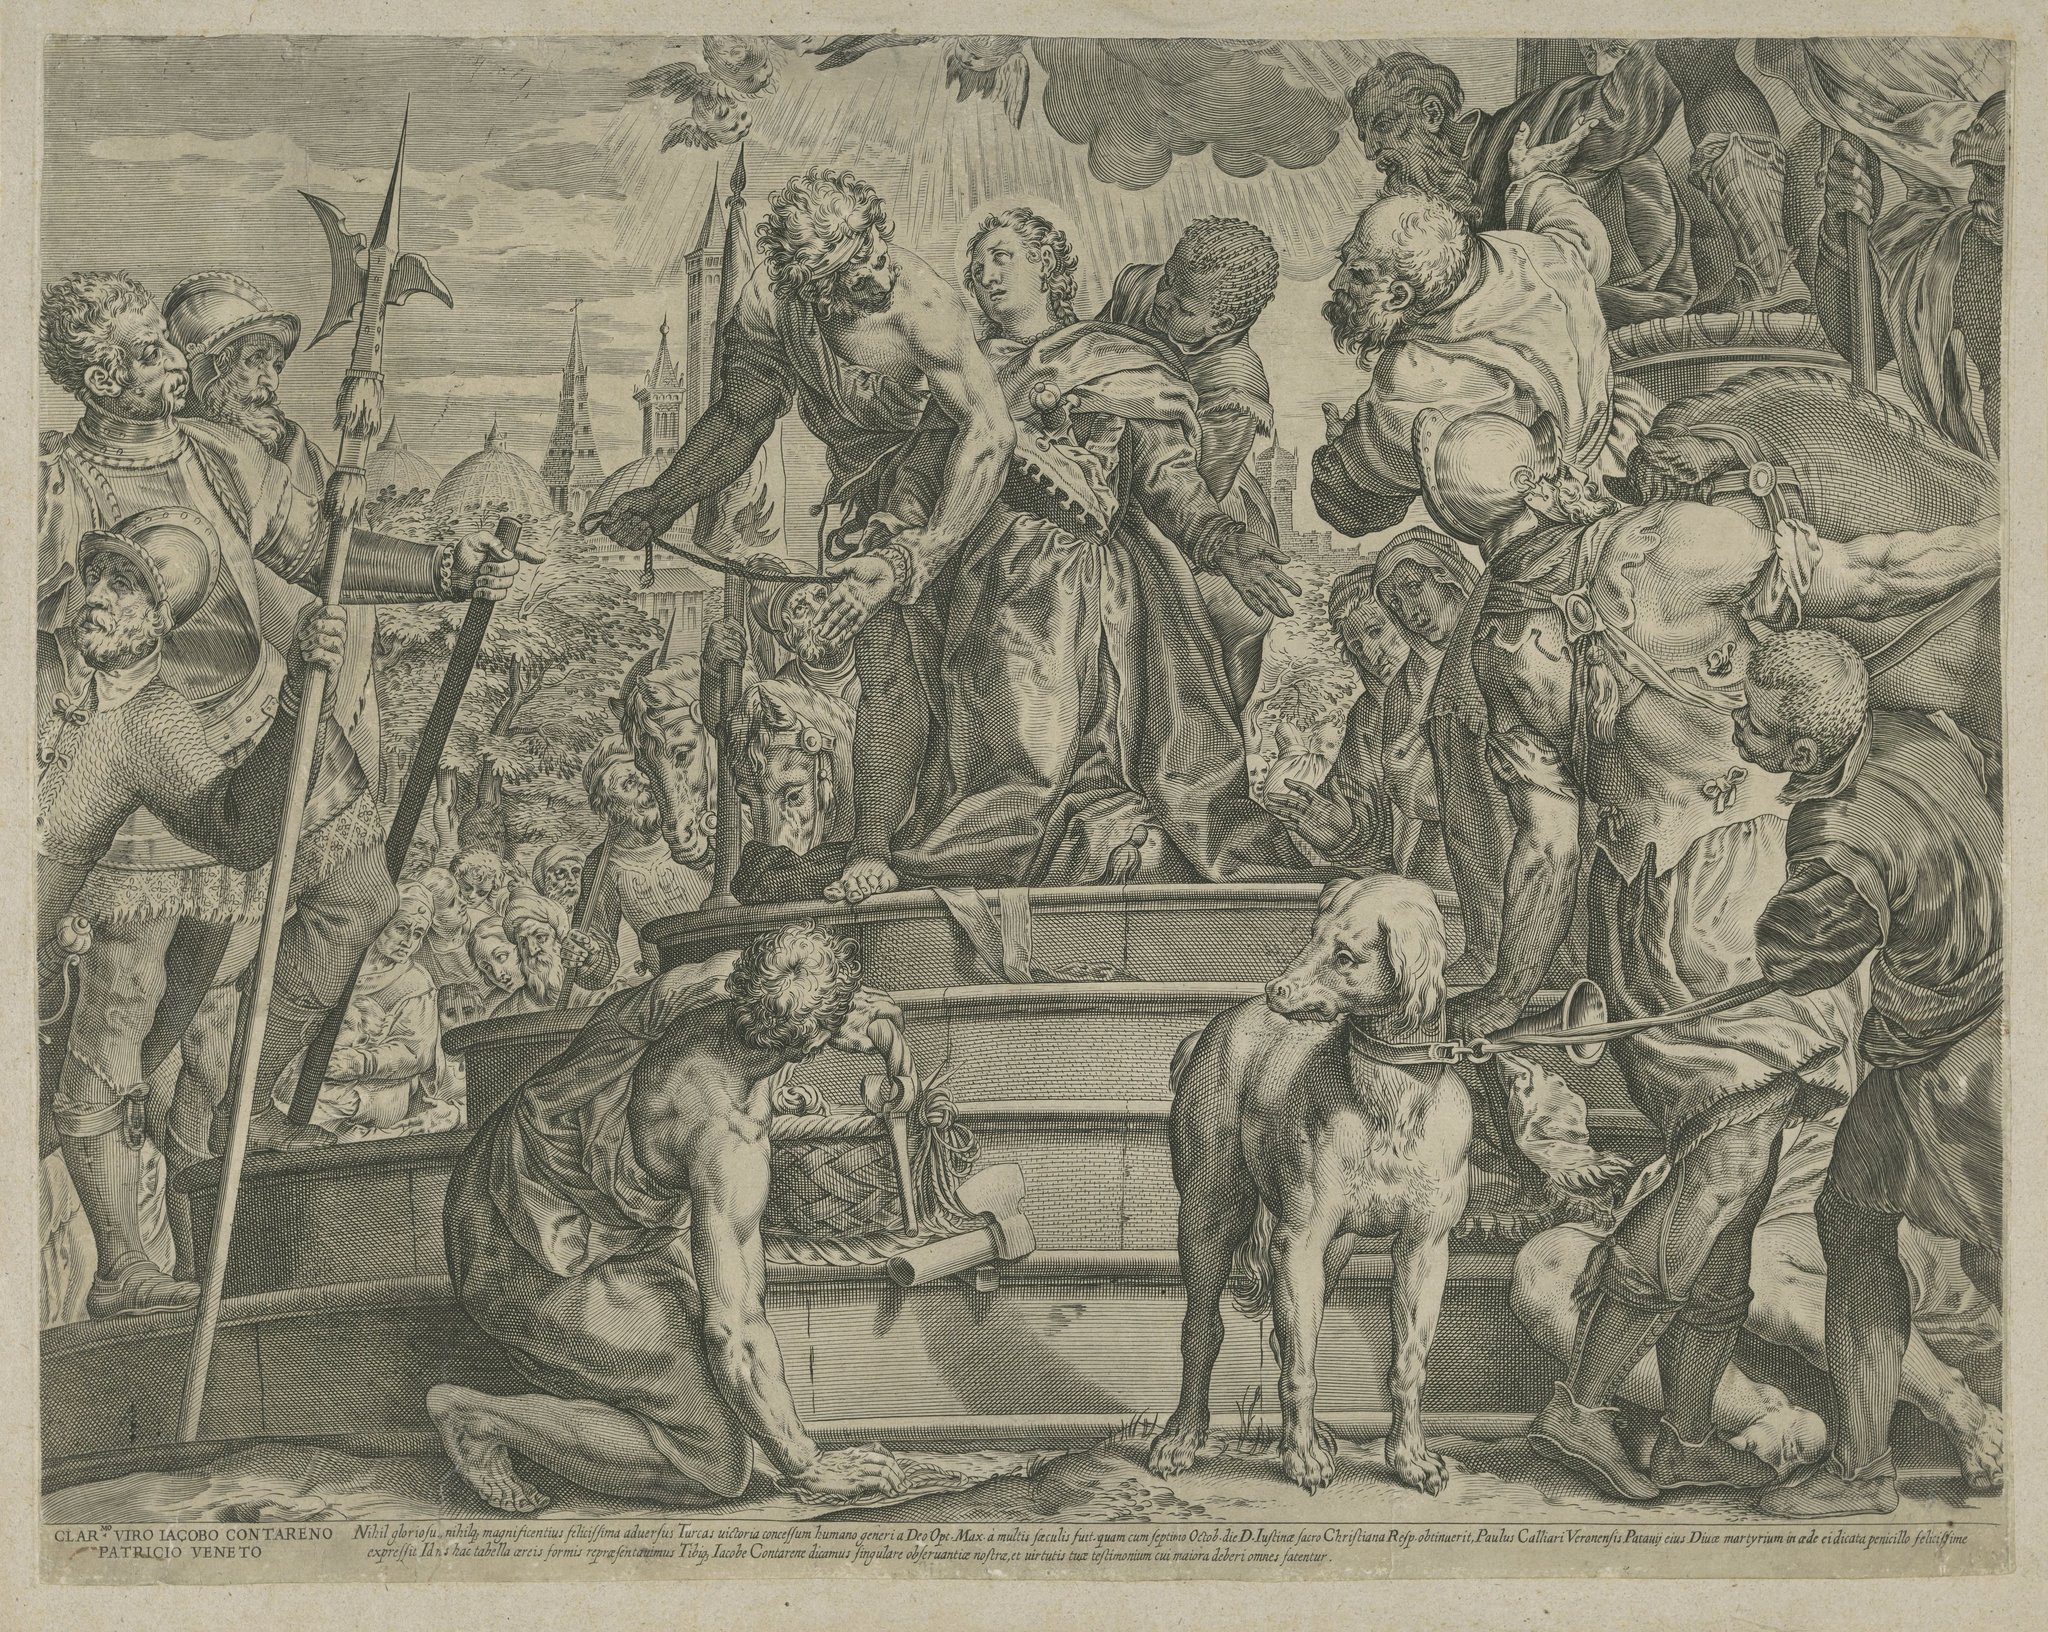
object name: print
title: Het martelaarschap van de heilige Justina van Padua (onderste helft)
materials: paper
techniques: engraving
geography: italy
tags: st. justina of padua is stabbed in the chest; christ, mary, and saints may appear to her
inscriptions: collector's mark: Lugt 240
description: De heilige Justina van Padua zit op een verhoging en wordt vastgebonden door soldaten. Ze heeft een zwaard in de borst. Op de achtergrond staan toeschouwers en een stad. Tekst in ondermarge.